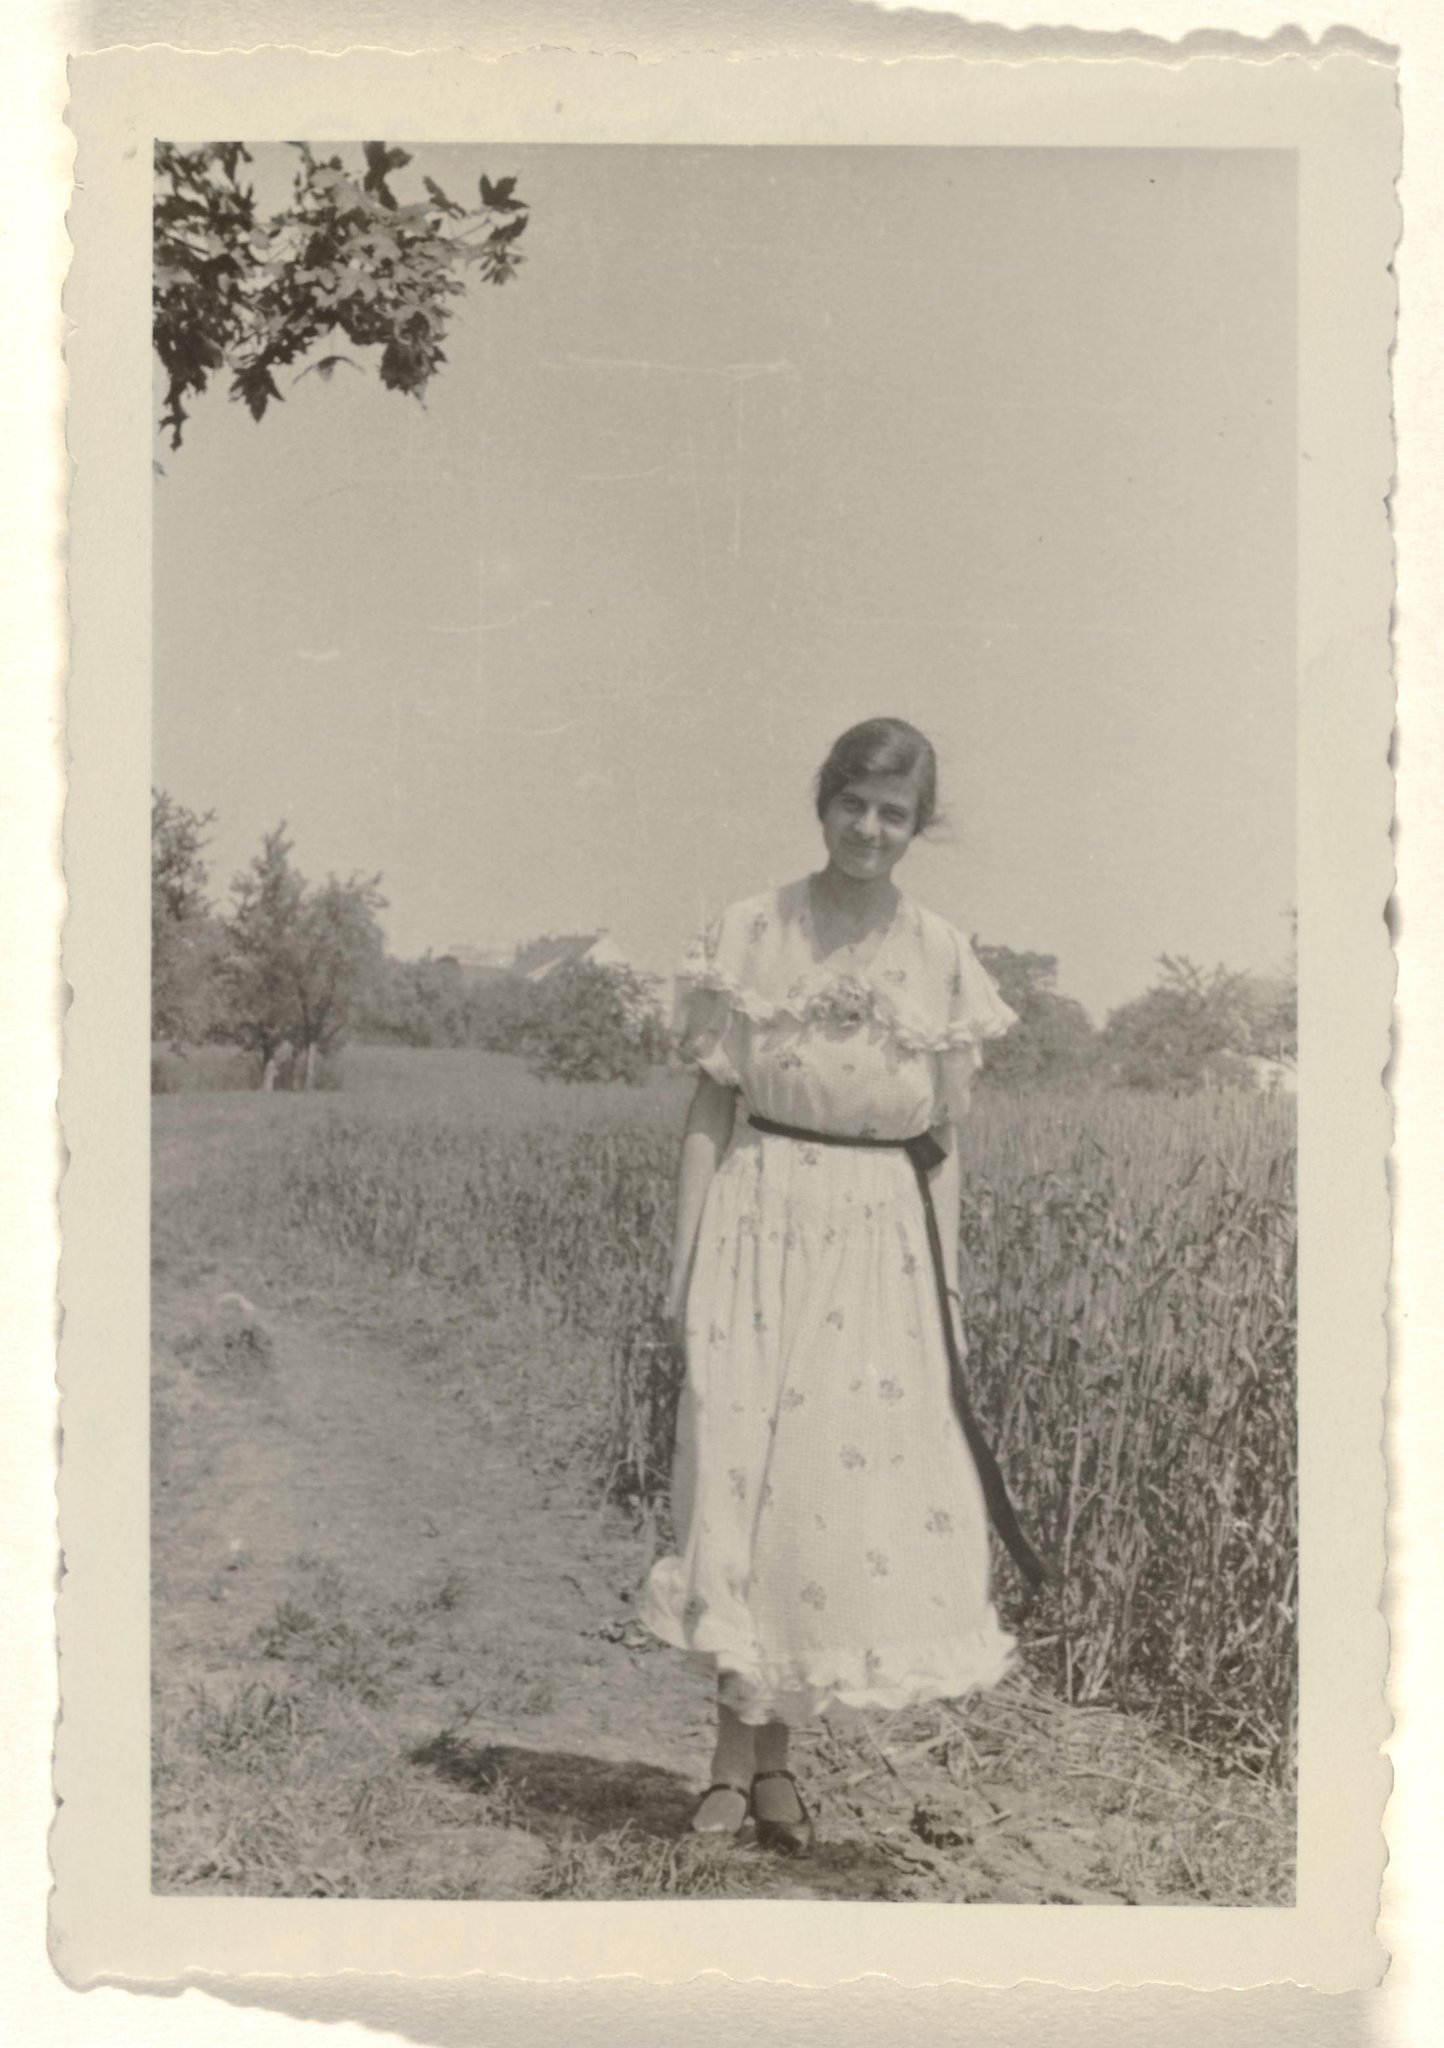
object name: photograph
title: Lid van de huishoudelijk staf van de familie Wachenheimer, mogelijk het kindermeisje, in gestipte jurk staand naast een veld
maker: Anonymous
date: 1933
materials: photographic support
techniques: gelatin silver print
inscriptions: date: ‘2. Juli 33.’